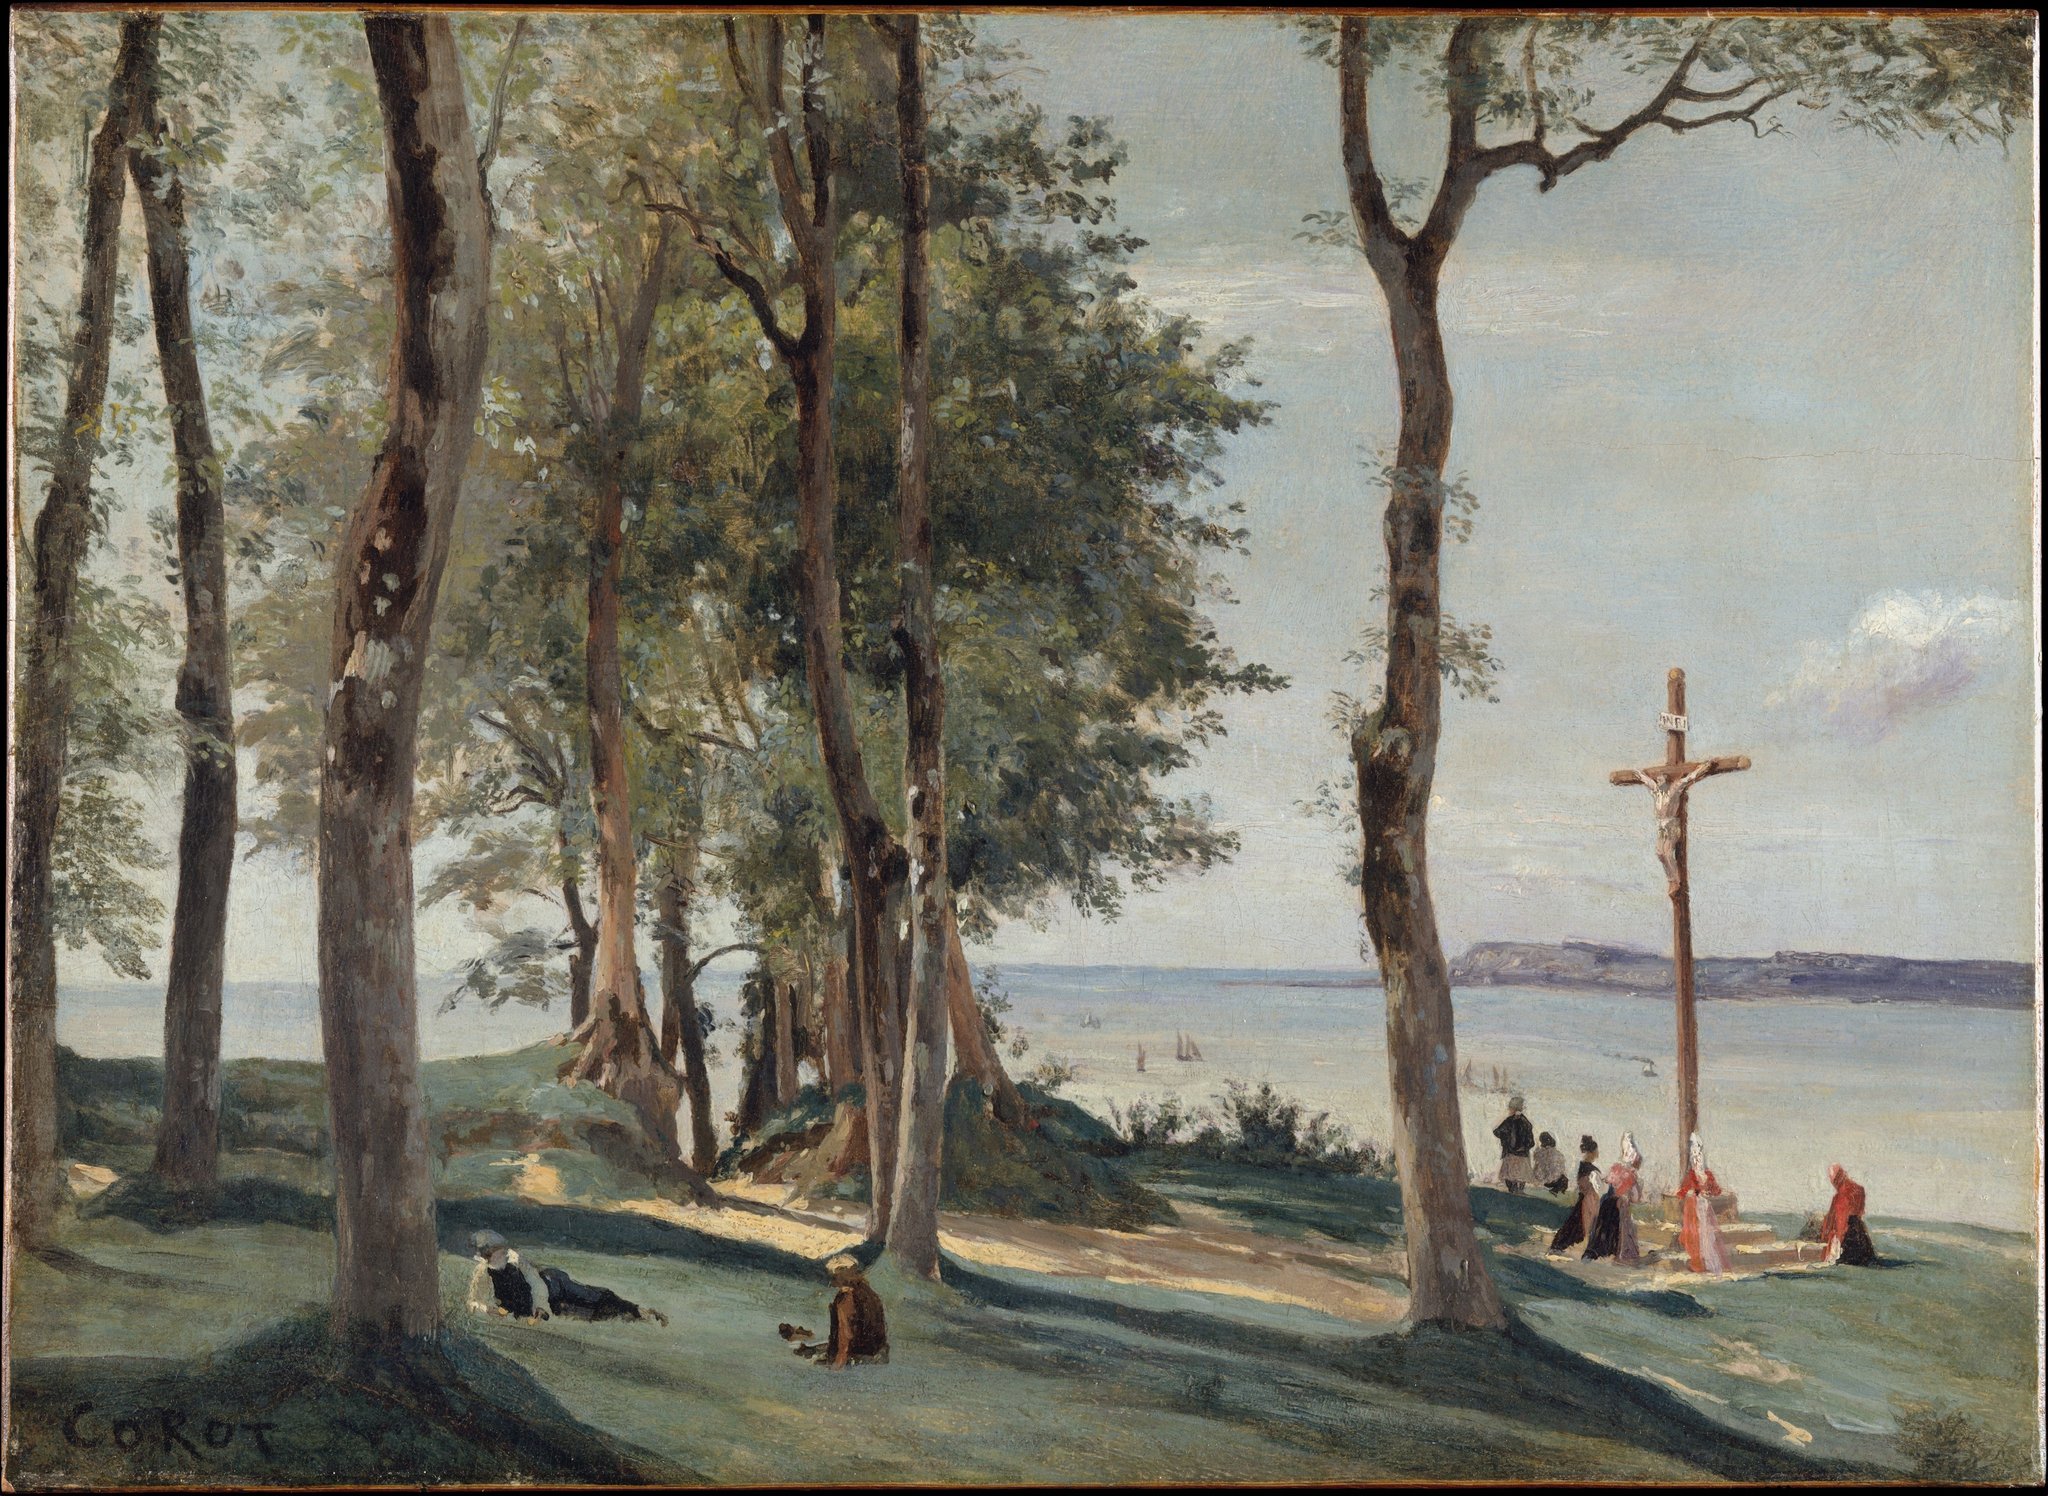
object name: painting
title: Honfleur: Calvary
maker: jean-baptiste-camille corot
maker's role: artist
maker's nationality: french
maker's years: 1796-1875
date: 1830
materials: oil, wood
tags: human figures,landscapes,christ,cross